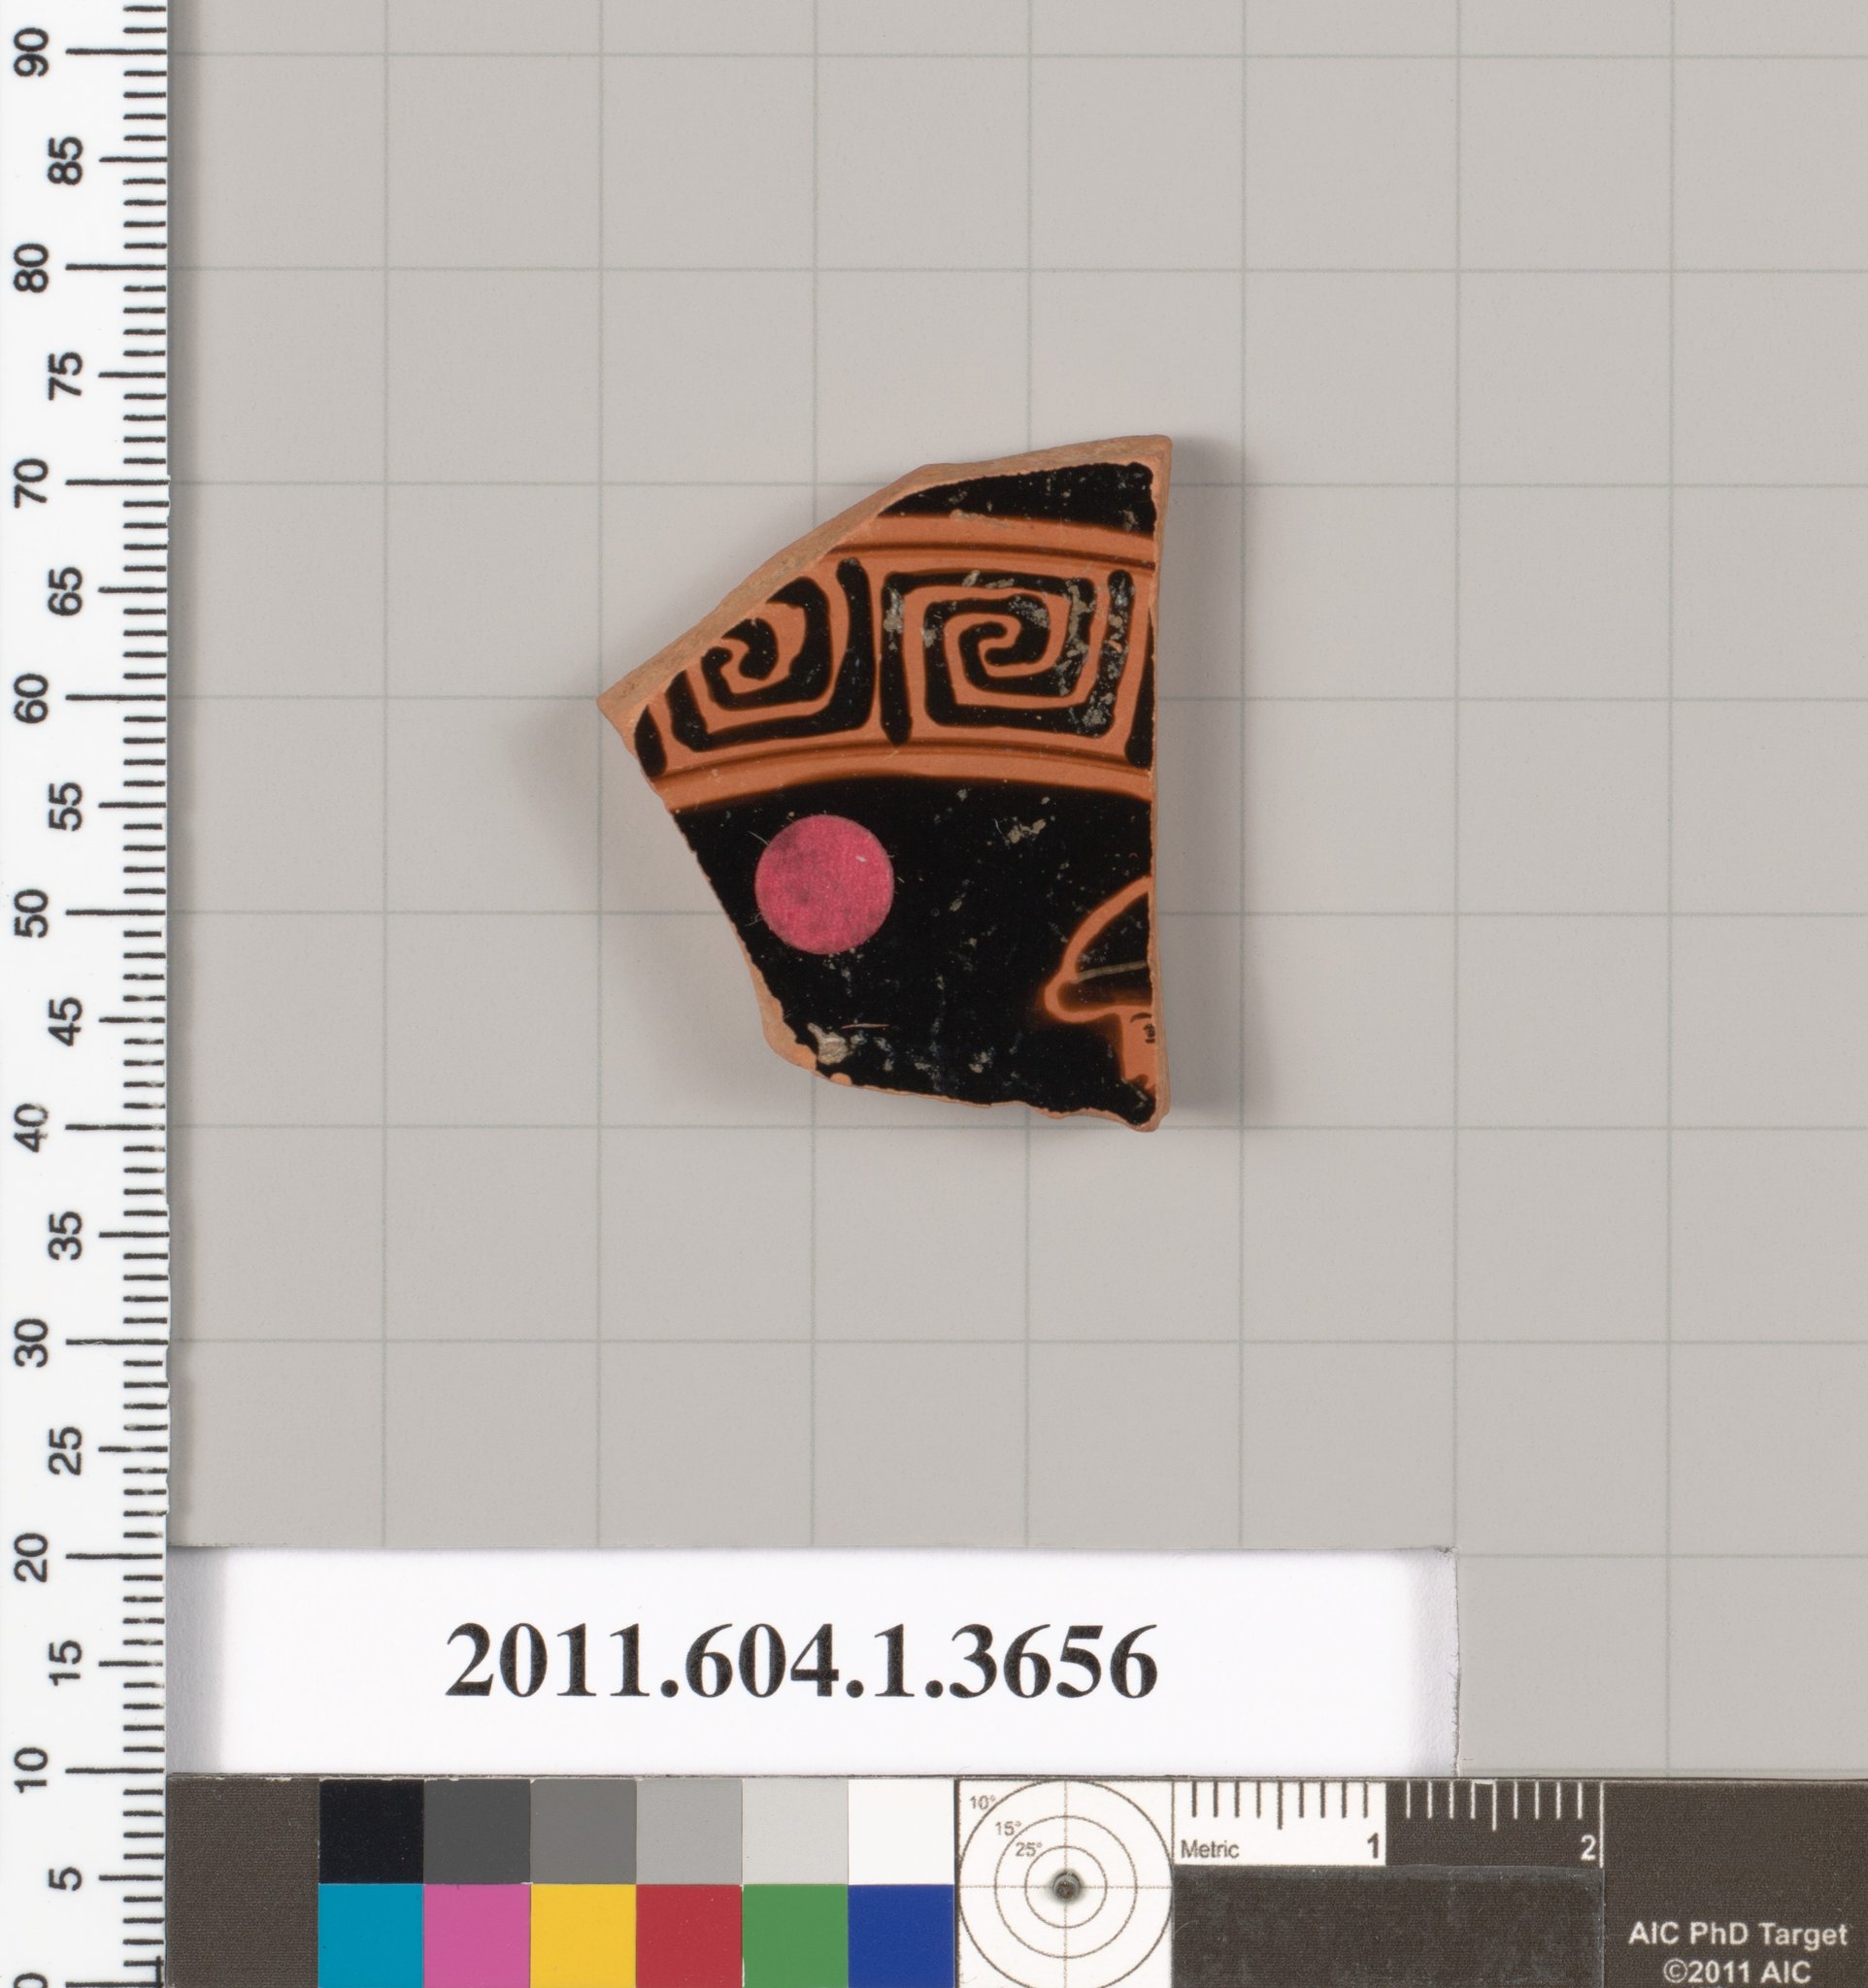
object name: kylix fragment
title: Terracotta fragment of a kylix (drinking cup)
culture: greek, attic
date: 475-451 BCE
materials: terracotta